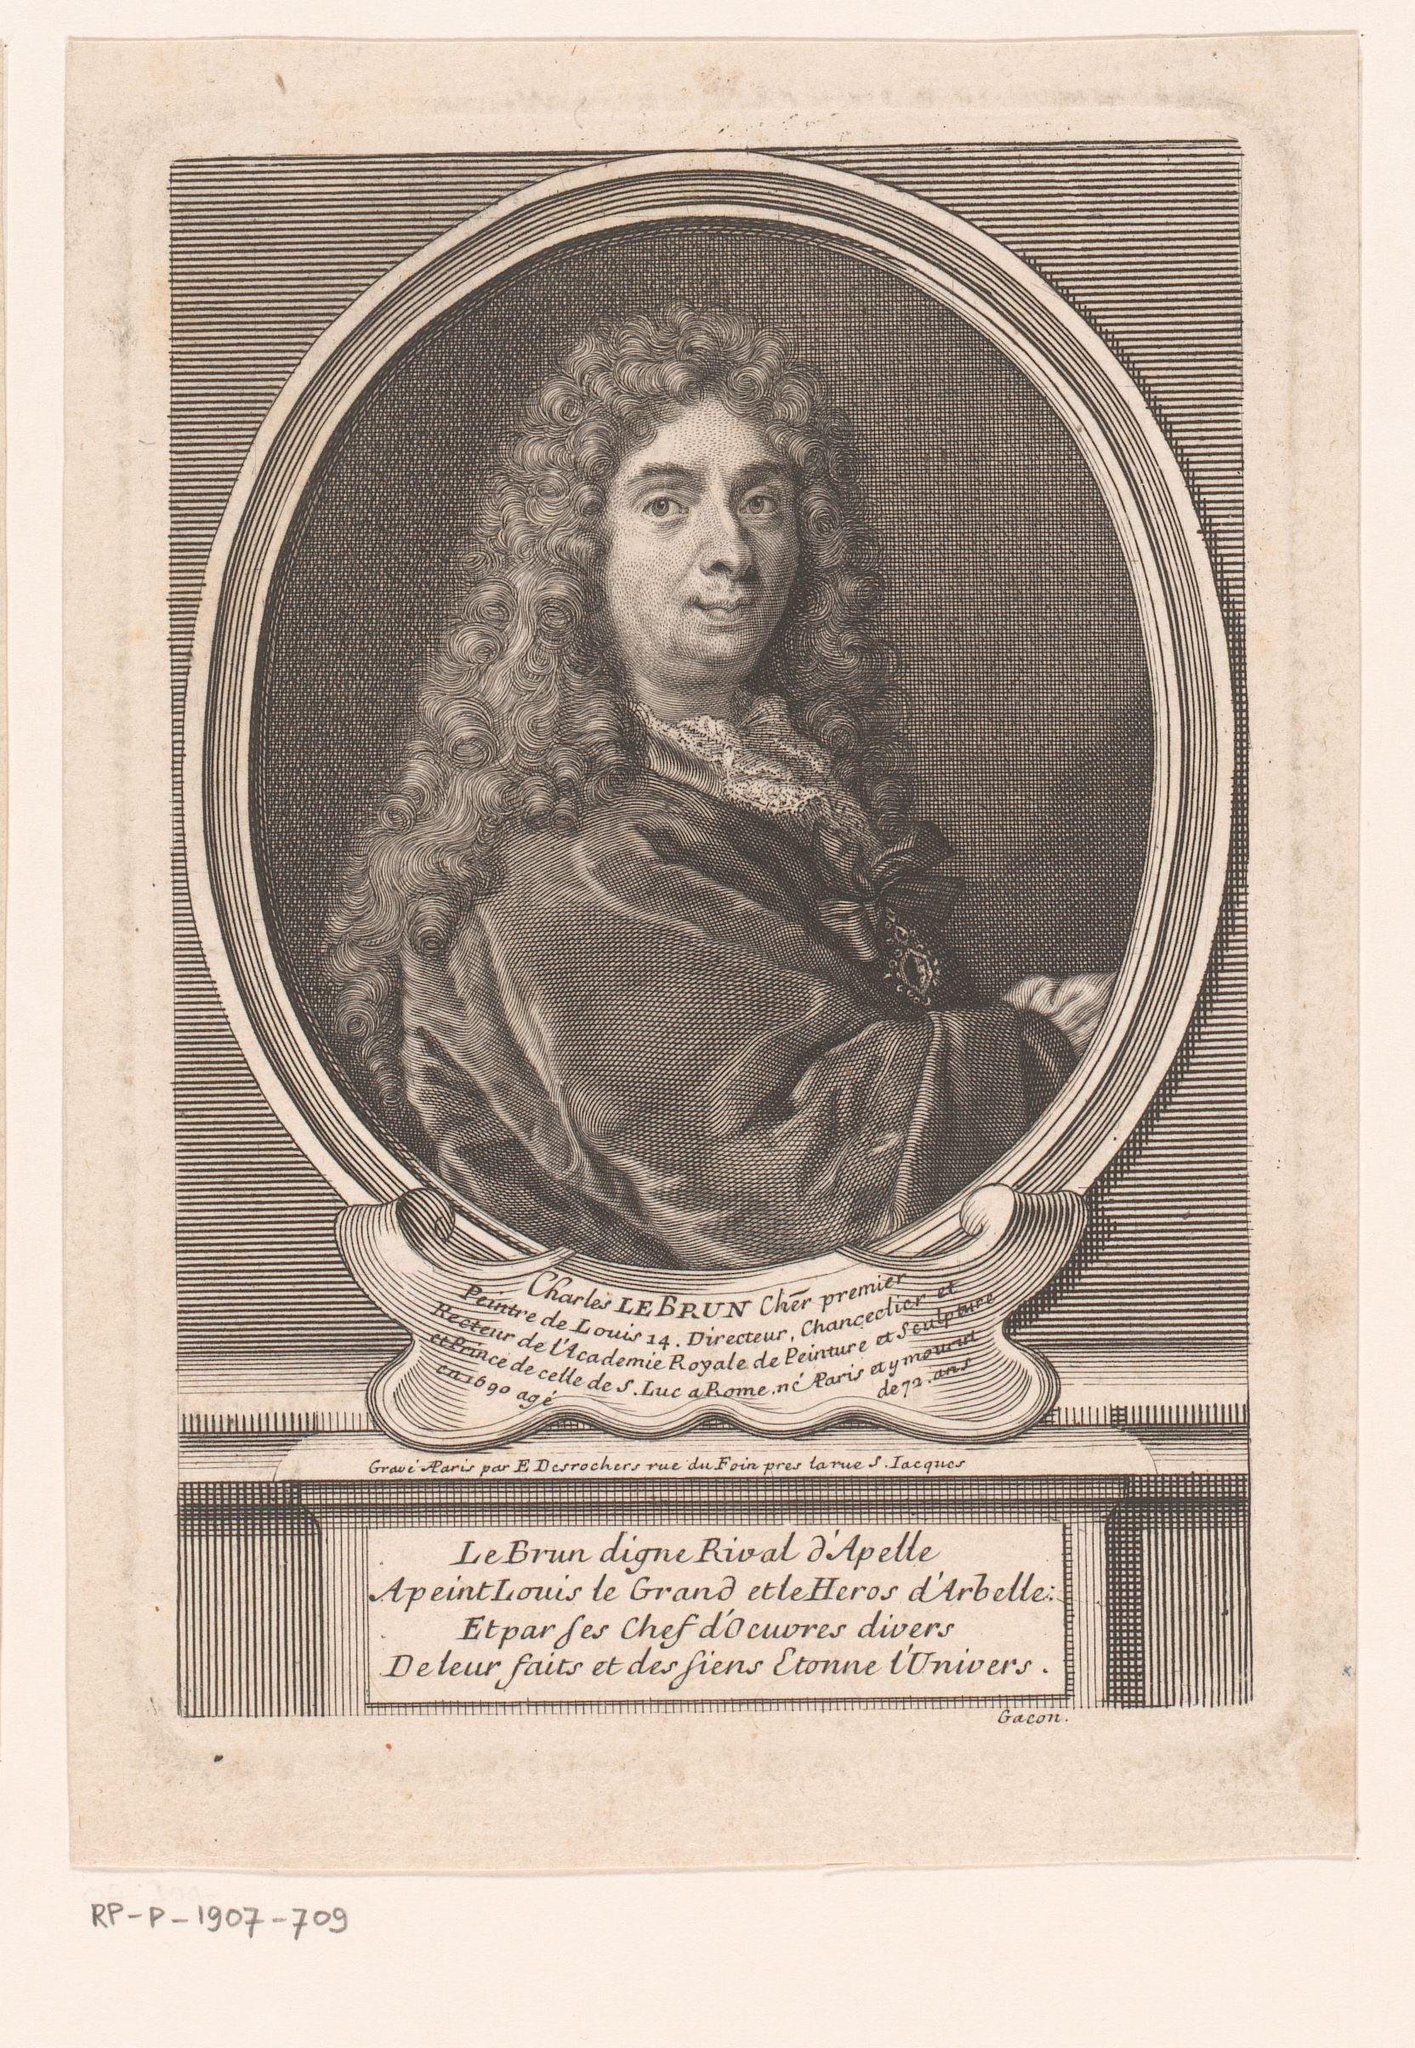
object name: print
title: Recueil de portraits (...)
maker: étienne desrochers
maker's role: print maker, publisher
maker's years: 1668-1741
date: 1726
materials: paper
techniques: engraving, etching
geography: paris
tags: paris, print maker, draughtsman, charles le brun, historical persons, portrait, self-portrait of artist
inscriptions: collector's mark: Lugt 2228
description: Behoort waarschijnlijk tot een serie portretten, grotendeels door Etienne Desrochers, getiteld: 'Recueil de portraits de personnes qui se sont distinguées tant dans les Armes que dans Belles-Lettres et les Arts, comme aussi la famille royale de France et autres cours étrangères'. De serie werd initieel uitgegeven door Desrochers en aangekondigd in 'Mercure' in mei 1726, p. 985. Echter was Desrochers reeds enkele jaren eerder begonnen met het uitgeven van de serie. Na de dood van Desrochers werd de serie voortgezet door Gilles Edme Petit. Een latere staat werd uitgegeven door Jean François Daumont in Parijs.